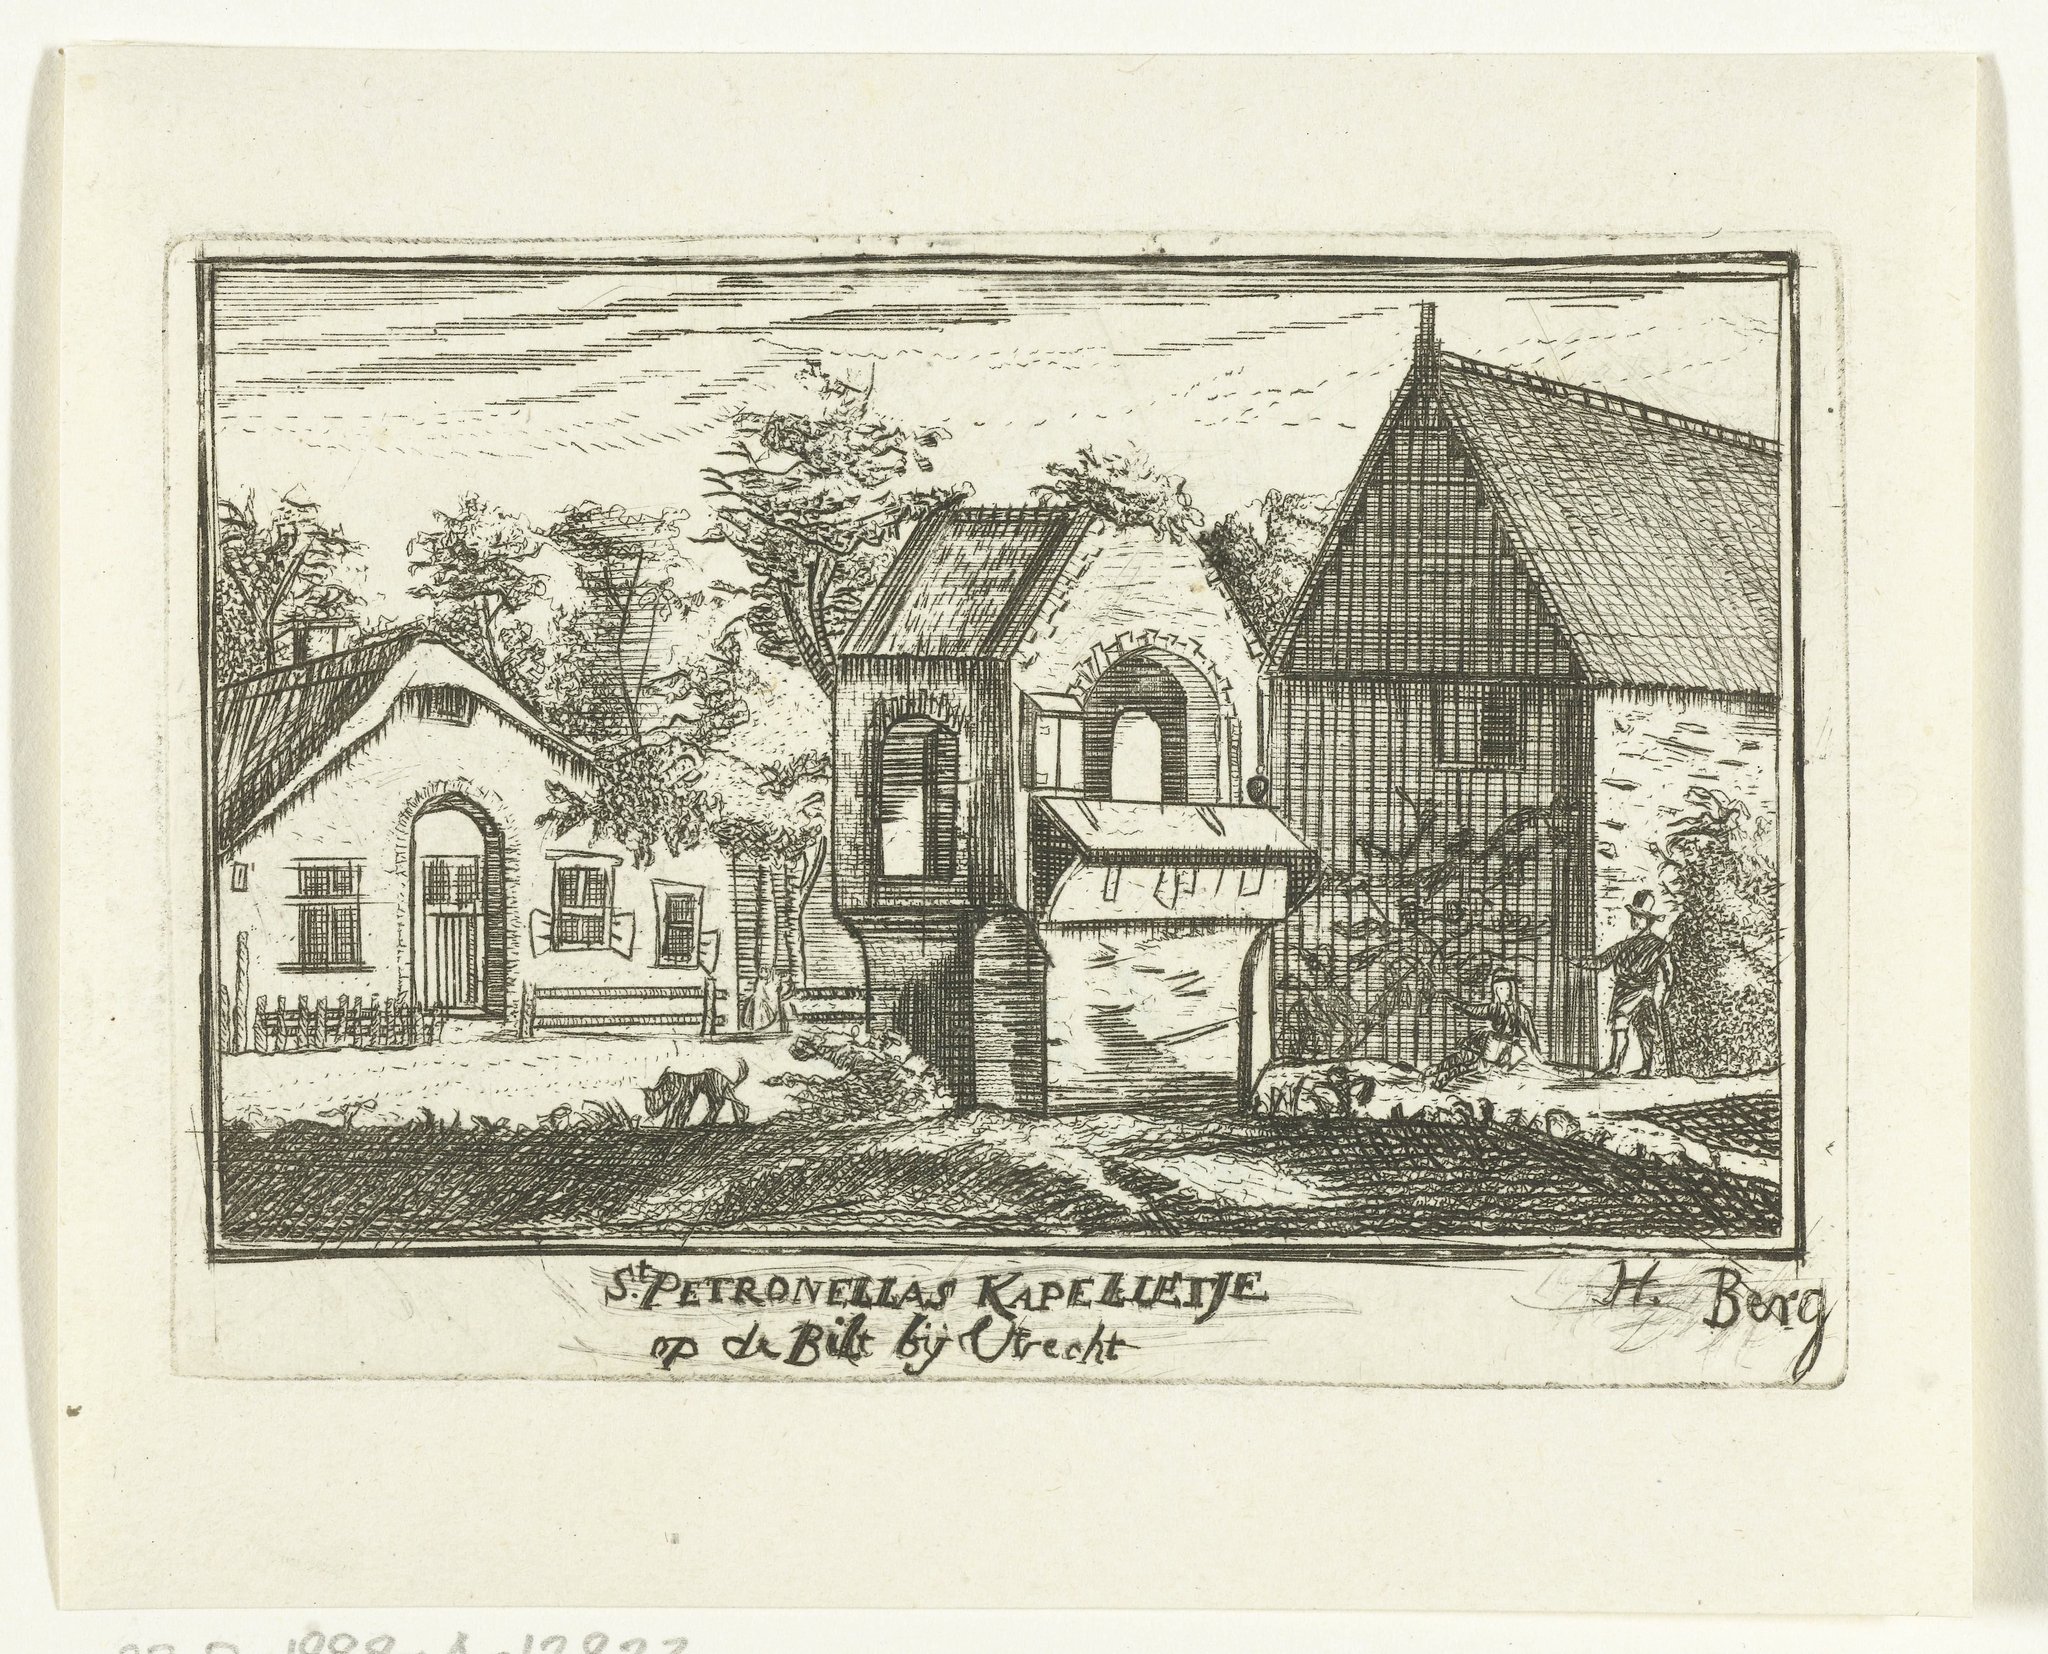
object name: print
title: Sint Petronella kapel in De Bilt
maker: hendrik berg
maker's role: print maker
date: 1765-1781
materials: paper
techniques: etching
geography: amsterdam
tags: church (exterior)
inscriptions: collector's mark: Lugt 2228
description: Kopie naar prent van Hendrik Spilman. Op verso staat als bron A. Rademaker vermeld van wie inderdaad een prent bekend is met hetzelfde onderwerp. De titel op deze prent van Hendrik Berg is duidelijk afgeleid van de titel op Spilman's prent.